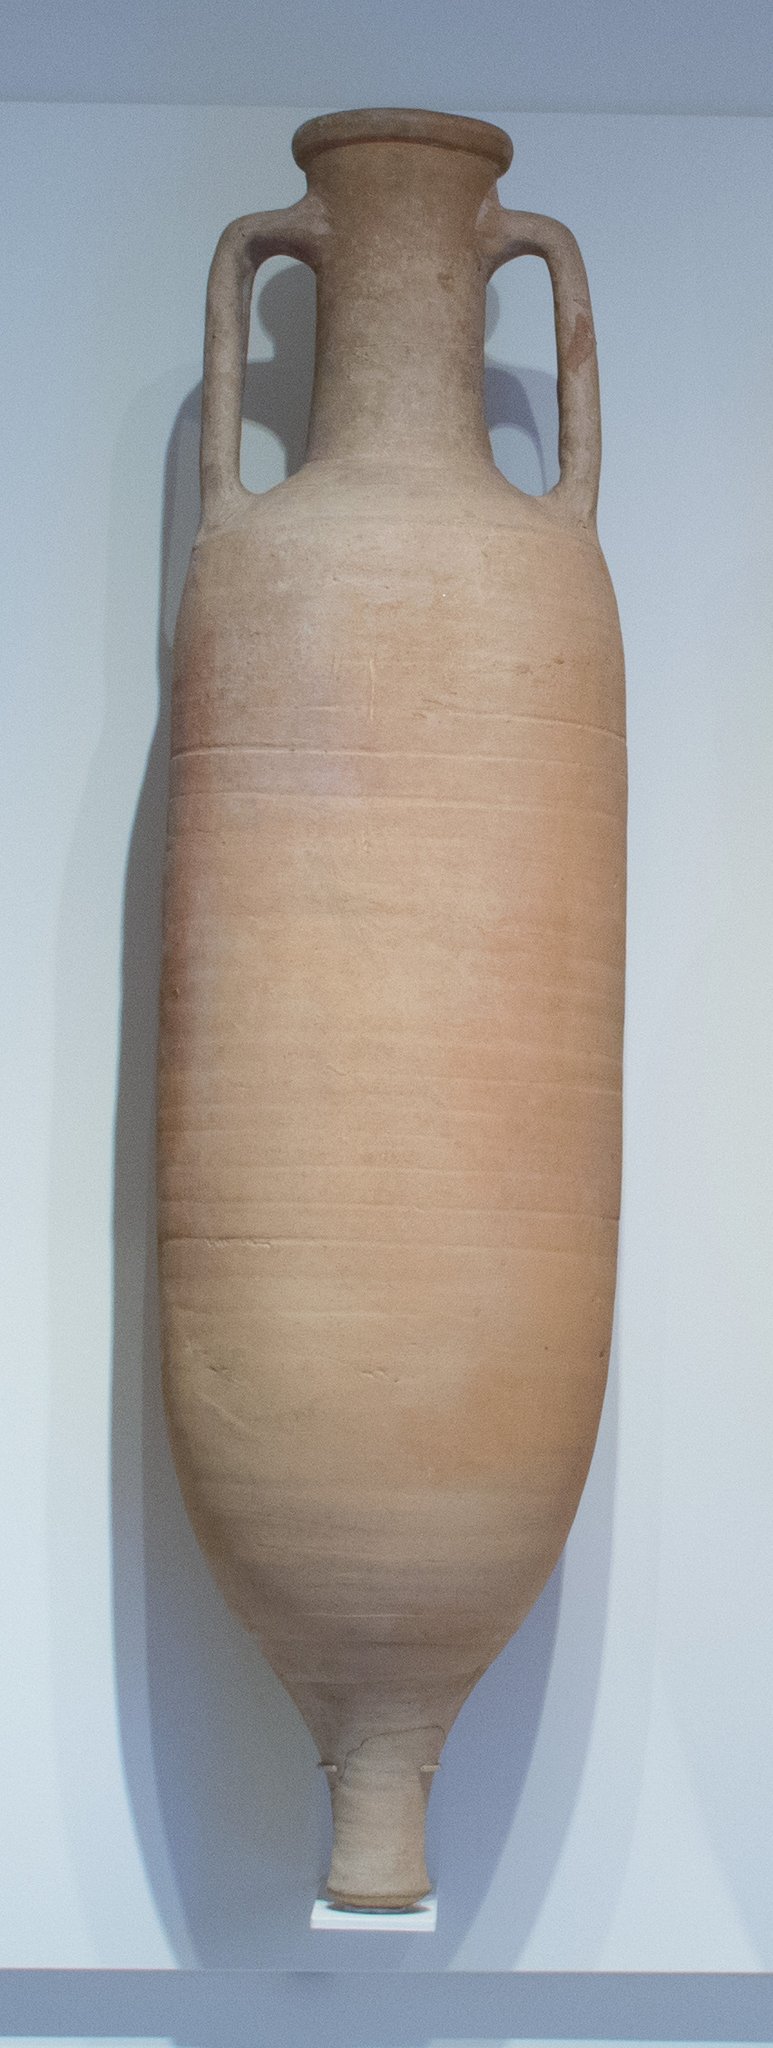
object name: amphora, pointed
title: Terracotta transport amphora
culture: roman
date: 67-166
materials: terracotta